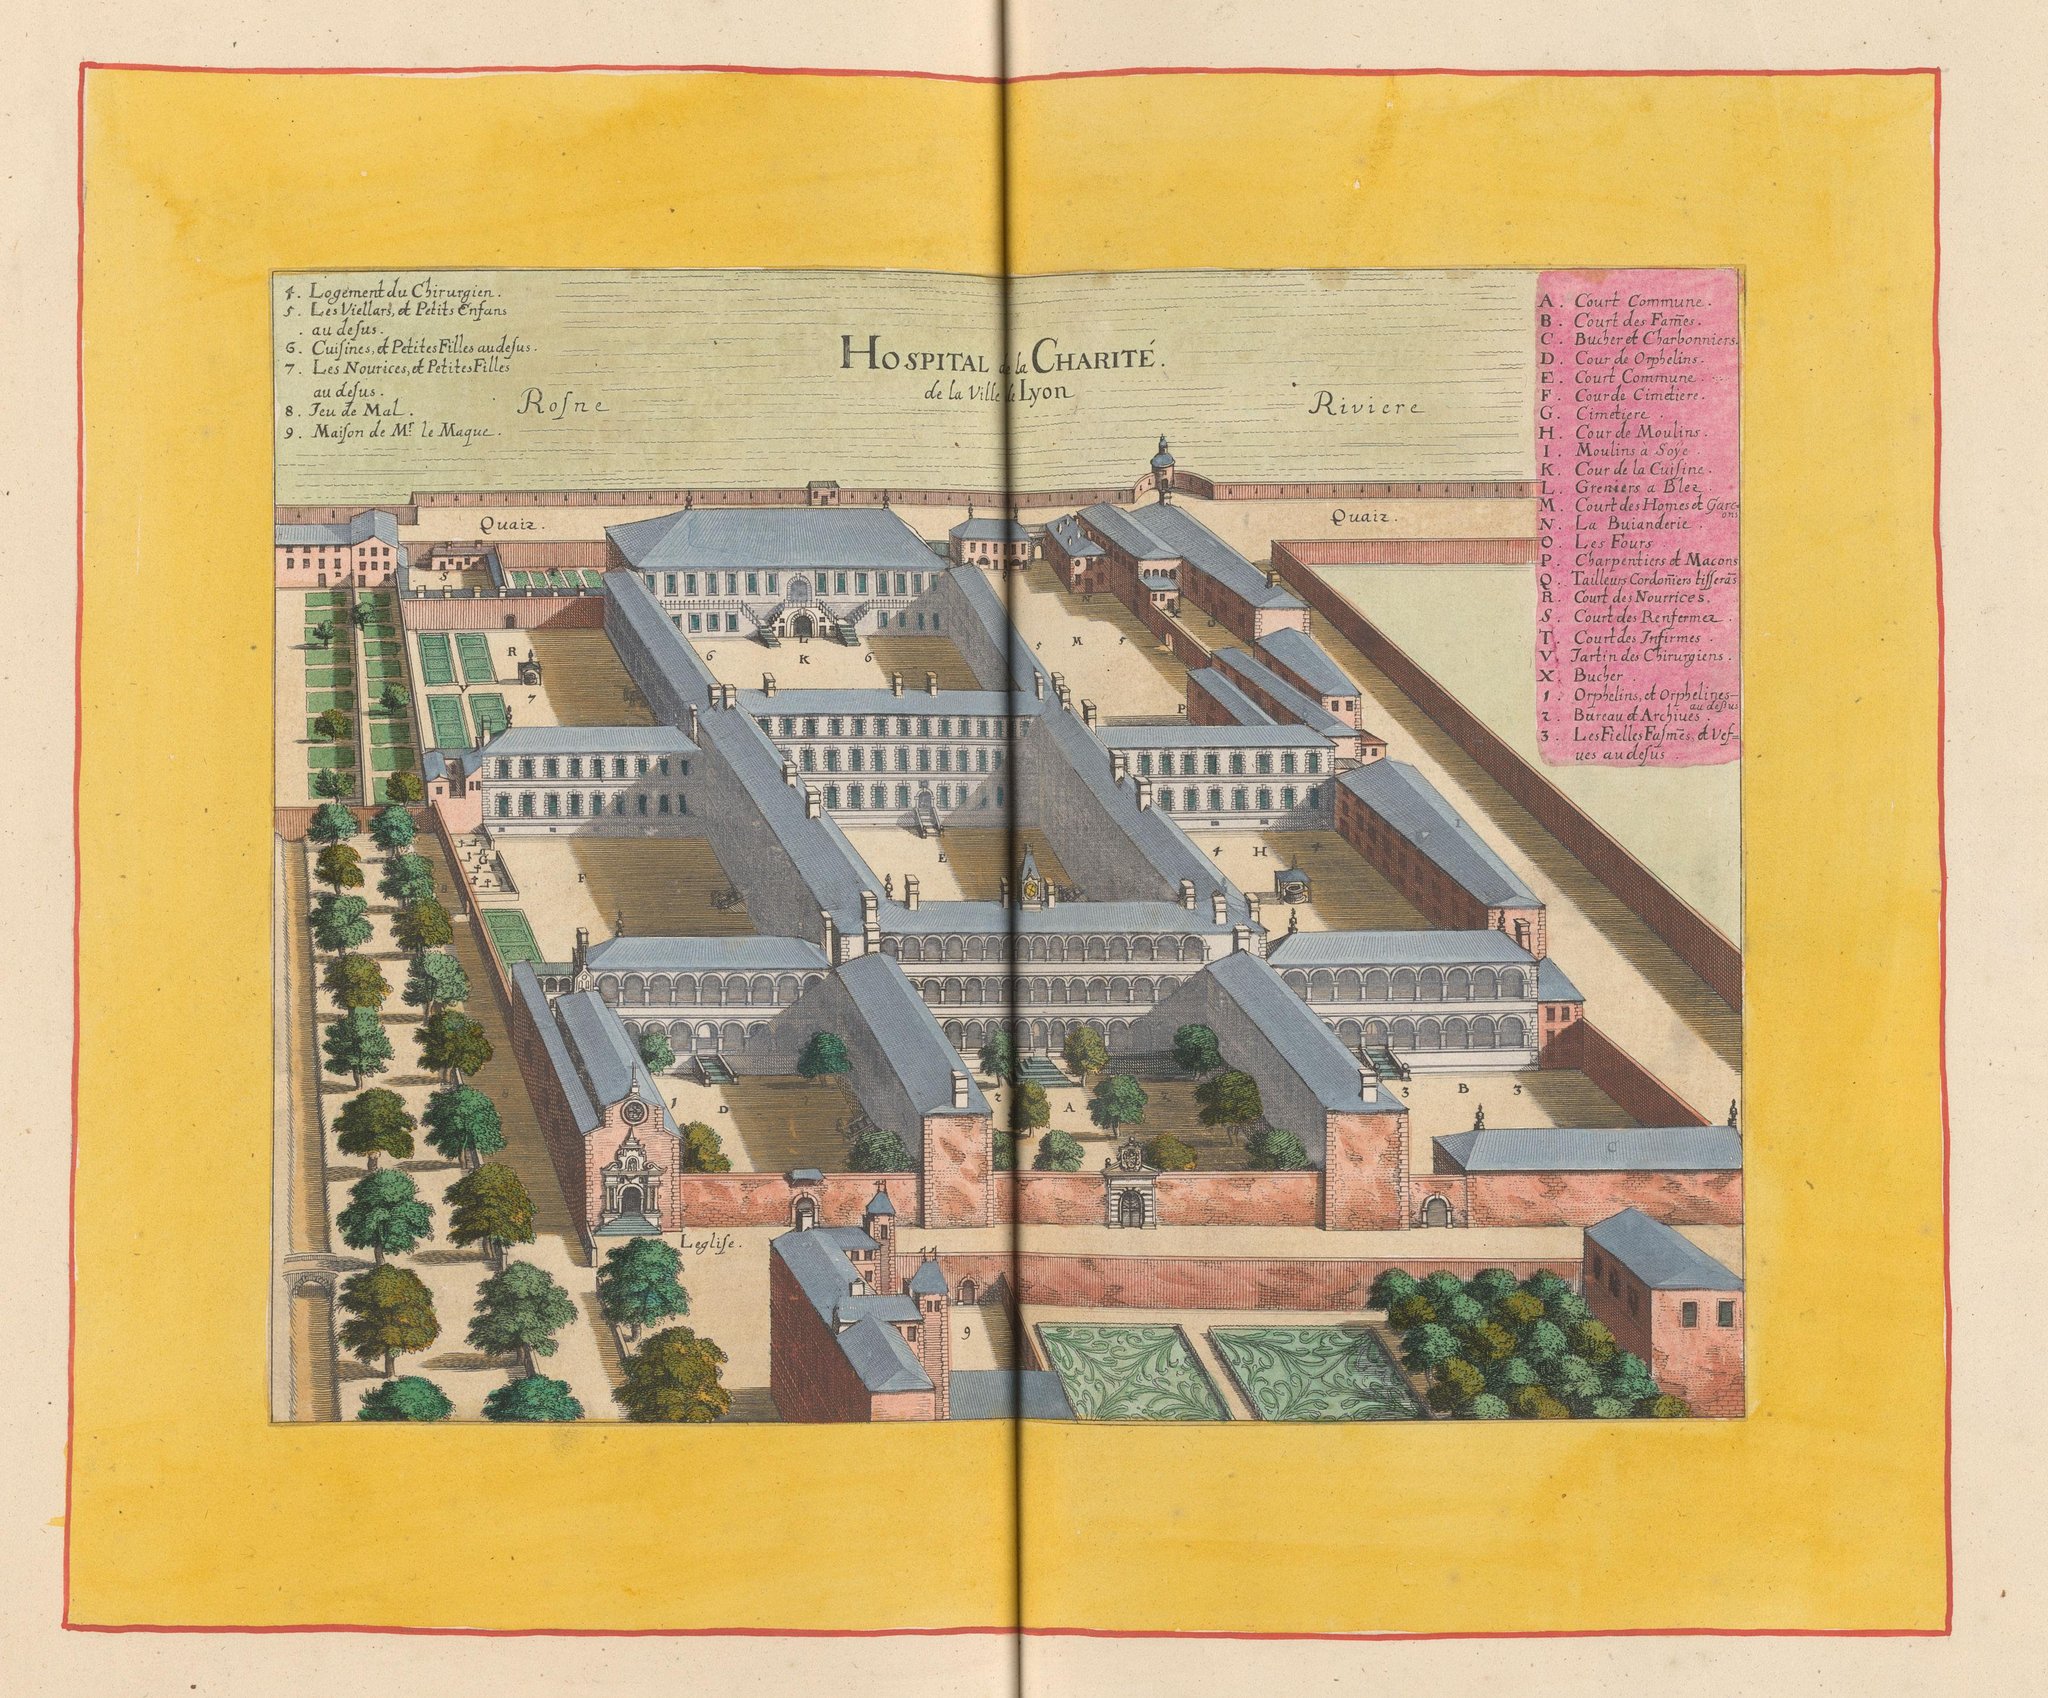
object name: album leaf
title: Gezicht op het Hôpital de la Charité de Lyon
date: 1657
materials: paper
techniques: engraving, etching, hand coloring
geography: the hague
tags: hospital, lyon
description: Prent uit: Zeiller, Martin. Topographia Galliae. 13 dln. Frankfurt: Caspar Merian, 1657, dl. 5, na p. 15.